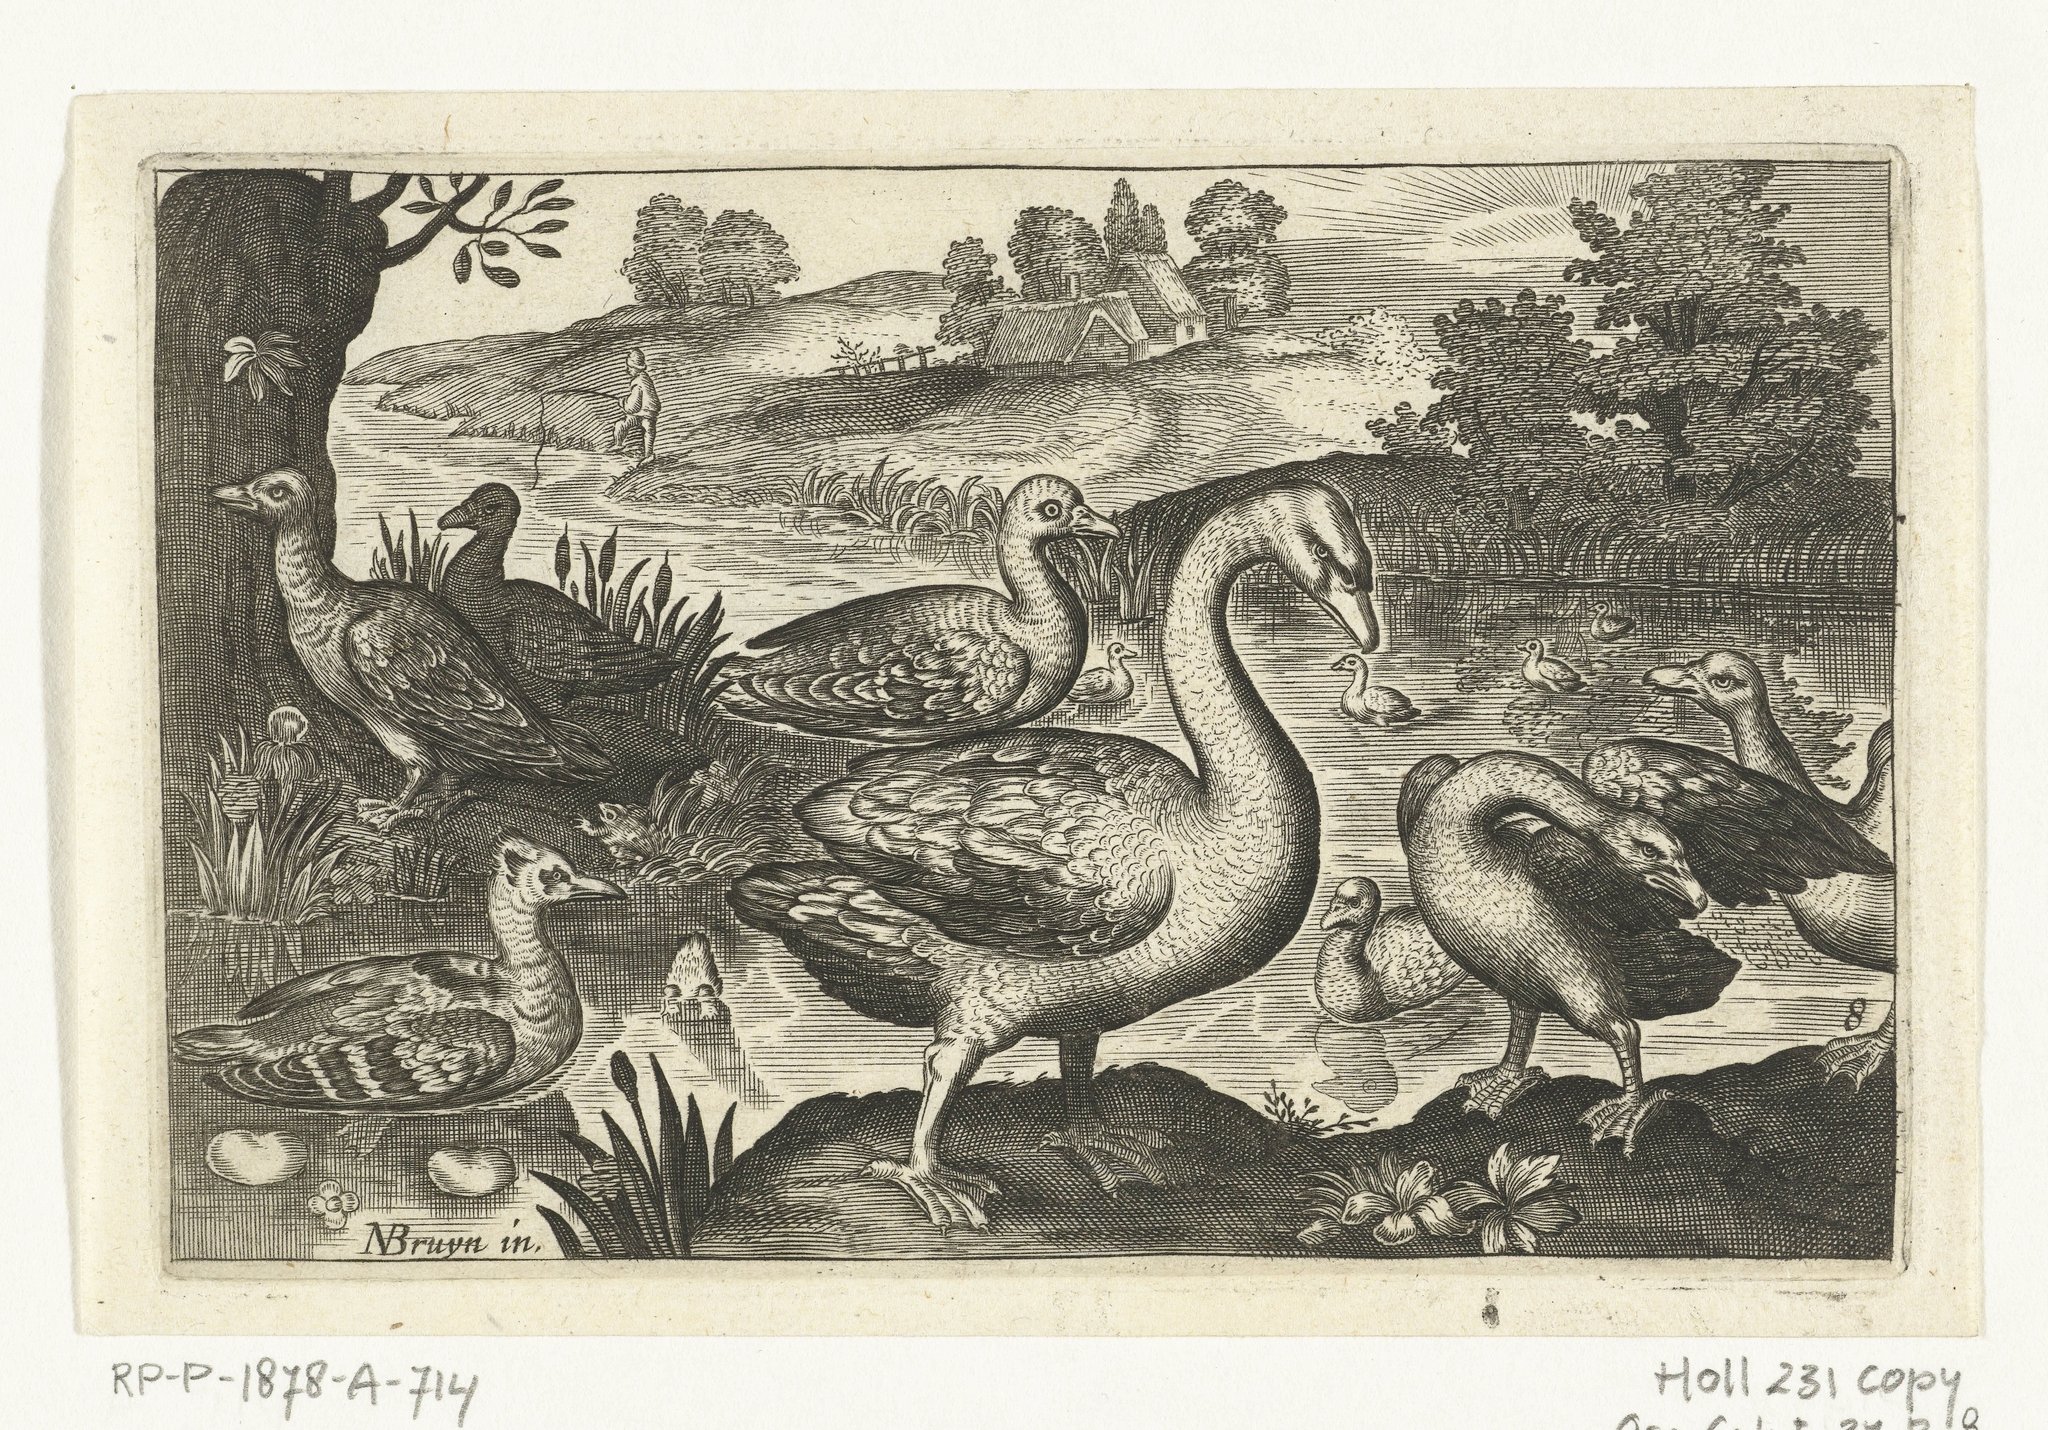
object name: print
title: Zwaan en ganzen en eenden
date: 1594-1644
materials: paper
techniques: engraving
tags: water-birds: goose, water-birds: swan, water-birds: duck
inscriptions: collector's mark: Lugt 2228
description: Kopie in spiegelbeeld naar prent van Nicolaes de Bruyn. Prent uit serie van twaalf prenten met vogels en insecten. Bij Hollstein zijn bladen van een andere serie prenten afgebeeld, zie De Groot 1988, p. 37.